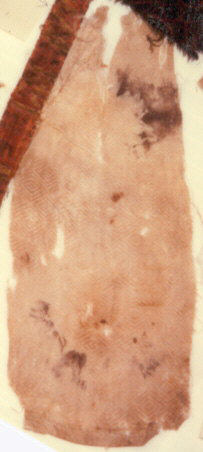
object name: textile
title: Textile fragment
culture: sasanian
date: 501-700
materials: silk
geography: iran